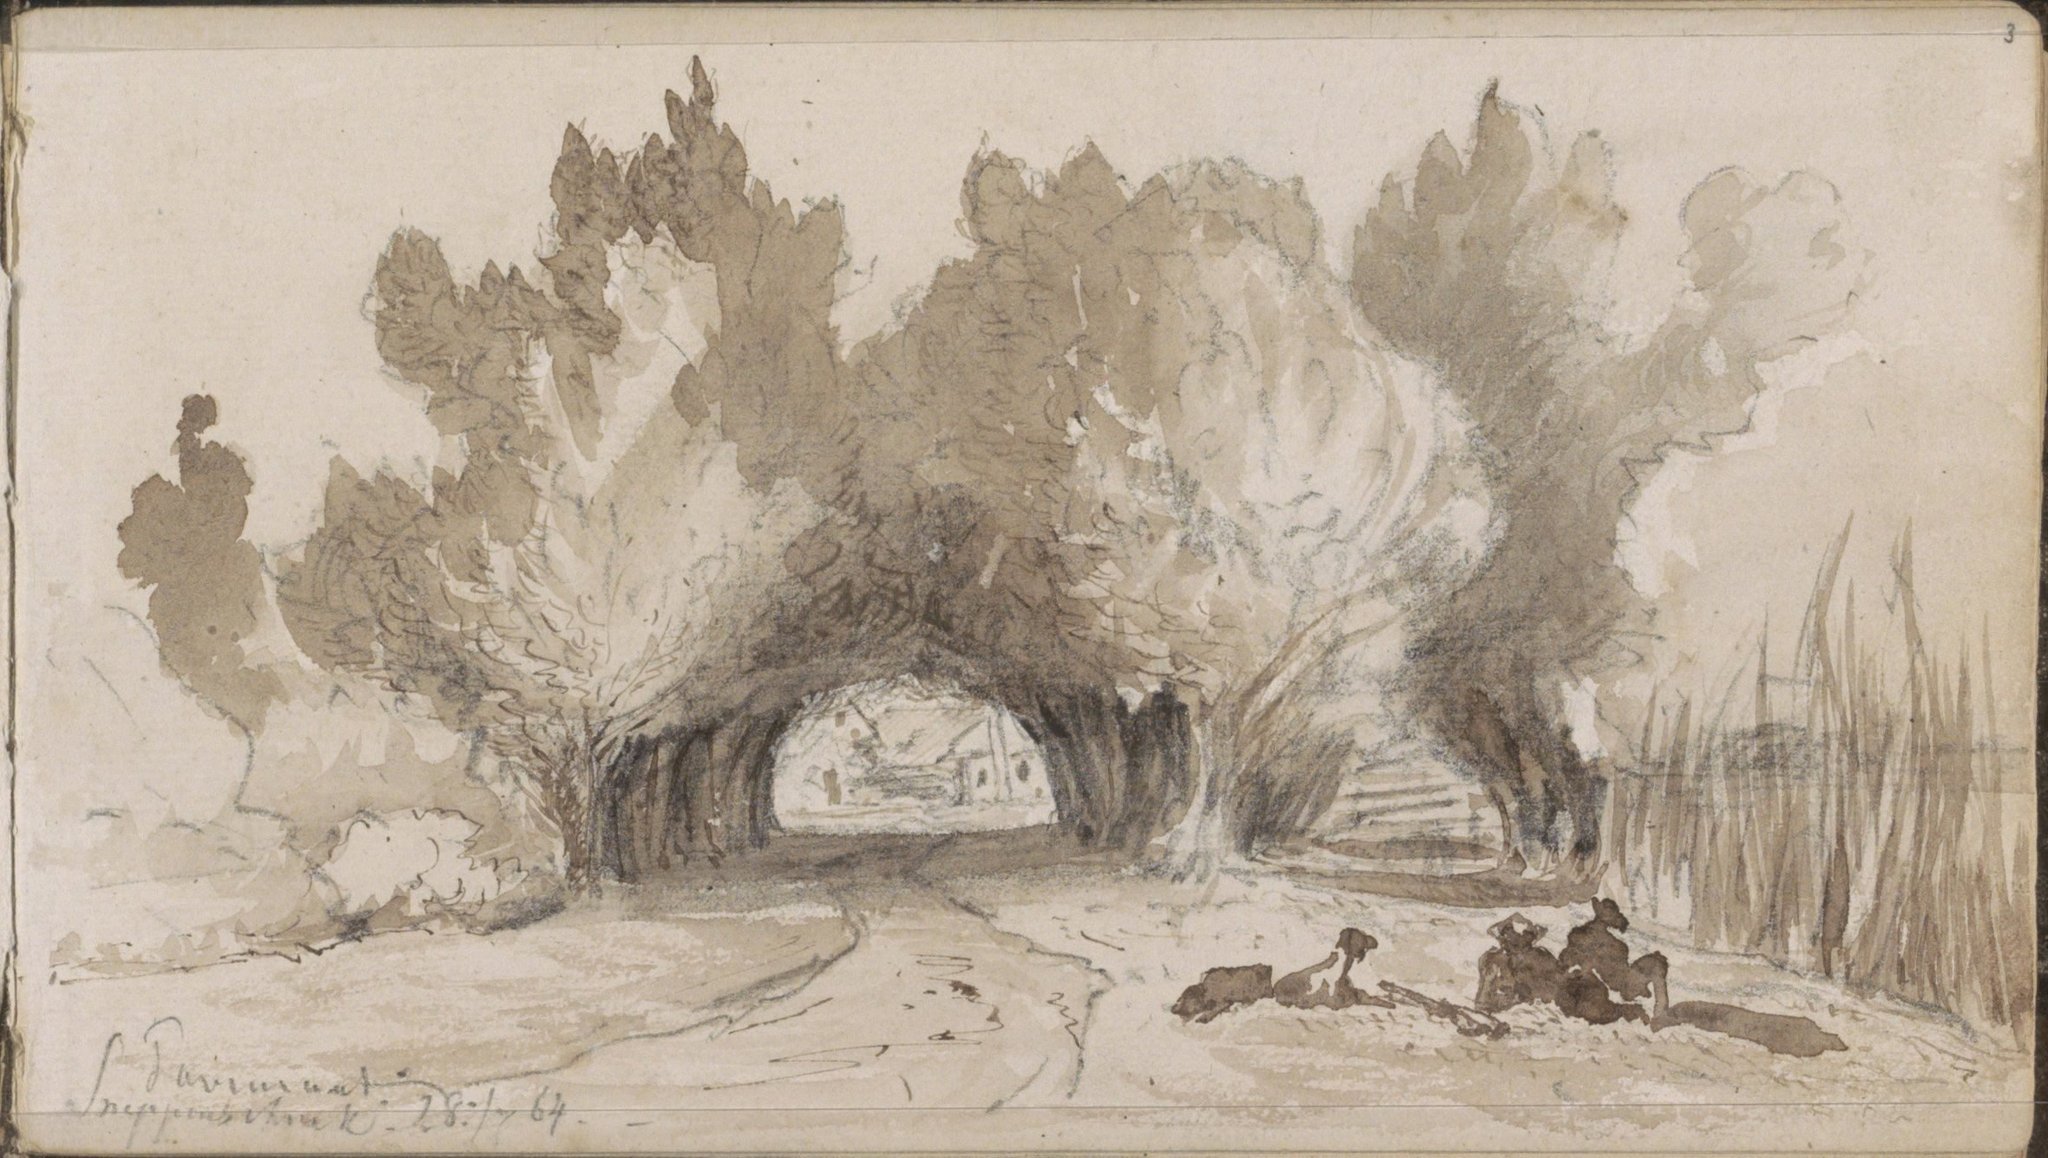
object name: sketchbook leaf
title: Laan tussen de bomen aan het water bij Sneppenschrik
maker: johannes tavenraat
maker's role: draughtsman, painter, print maker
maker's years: 1809-1881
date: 1807-1864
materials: ink, paper, pencil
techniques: brush, pen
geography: capelle aan den ijssel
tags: trees, landscapes with waters, waterscapes, seascapes (in the temperate zone), road, path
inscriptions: signature: ‘Tavenraat’, date and inscription: ‘Sneppenschrik 28/7 64’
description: Op de voorgrond zitten enkele figuren met honden langs de waterkant. Blad 3 recto uit een schetsboek met 98 bladen.